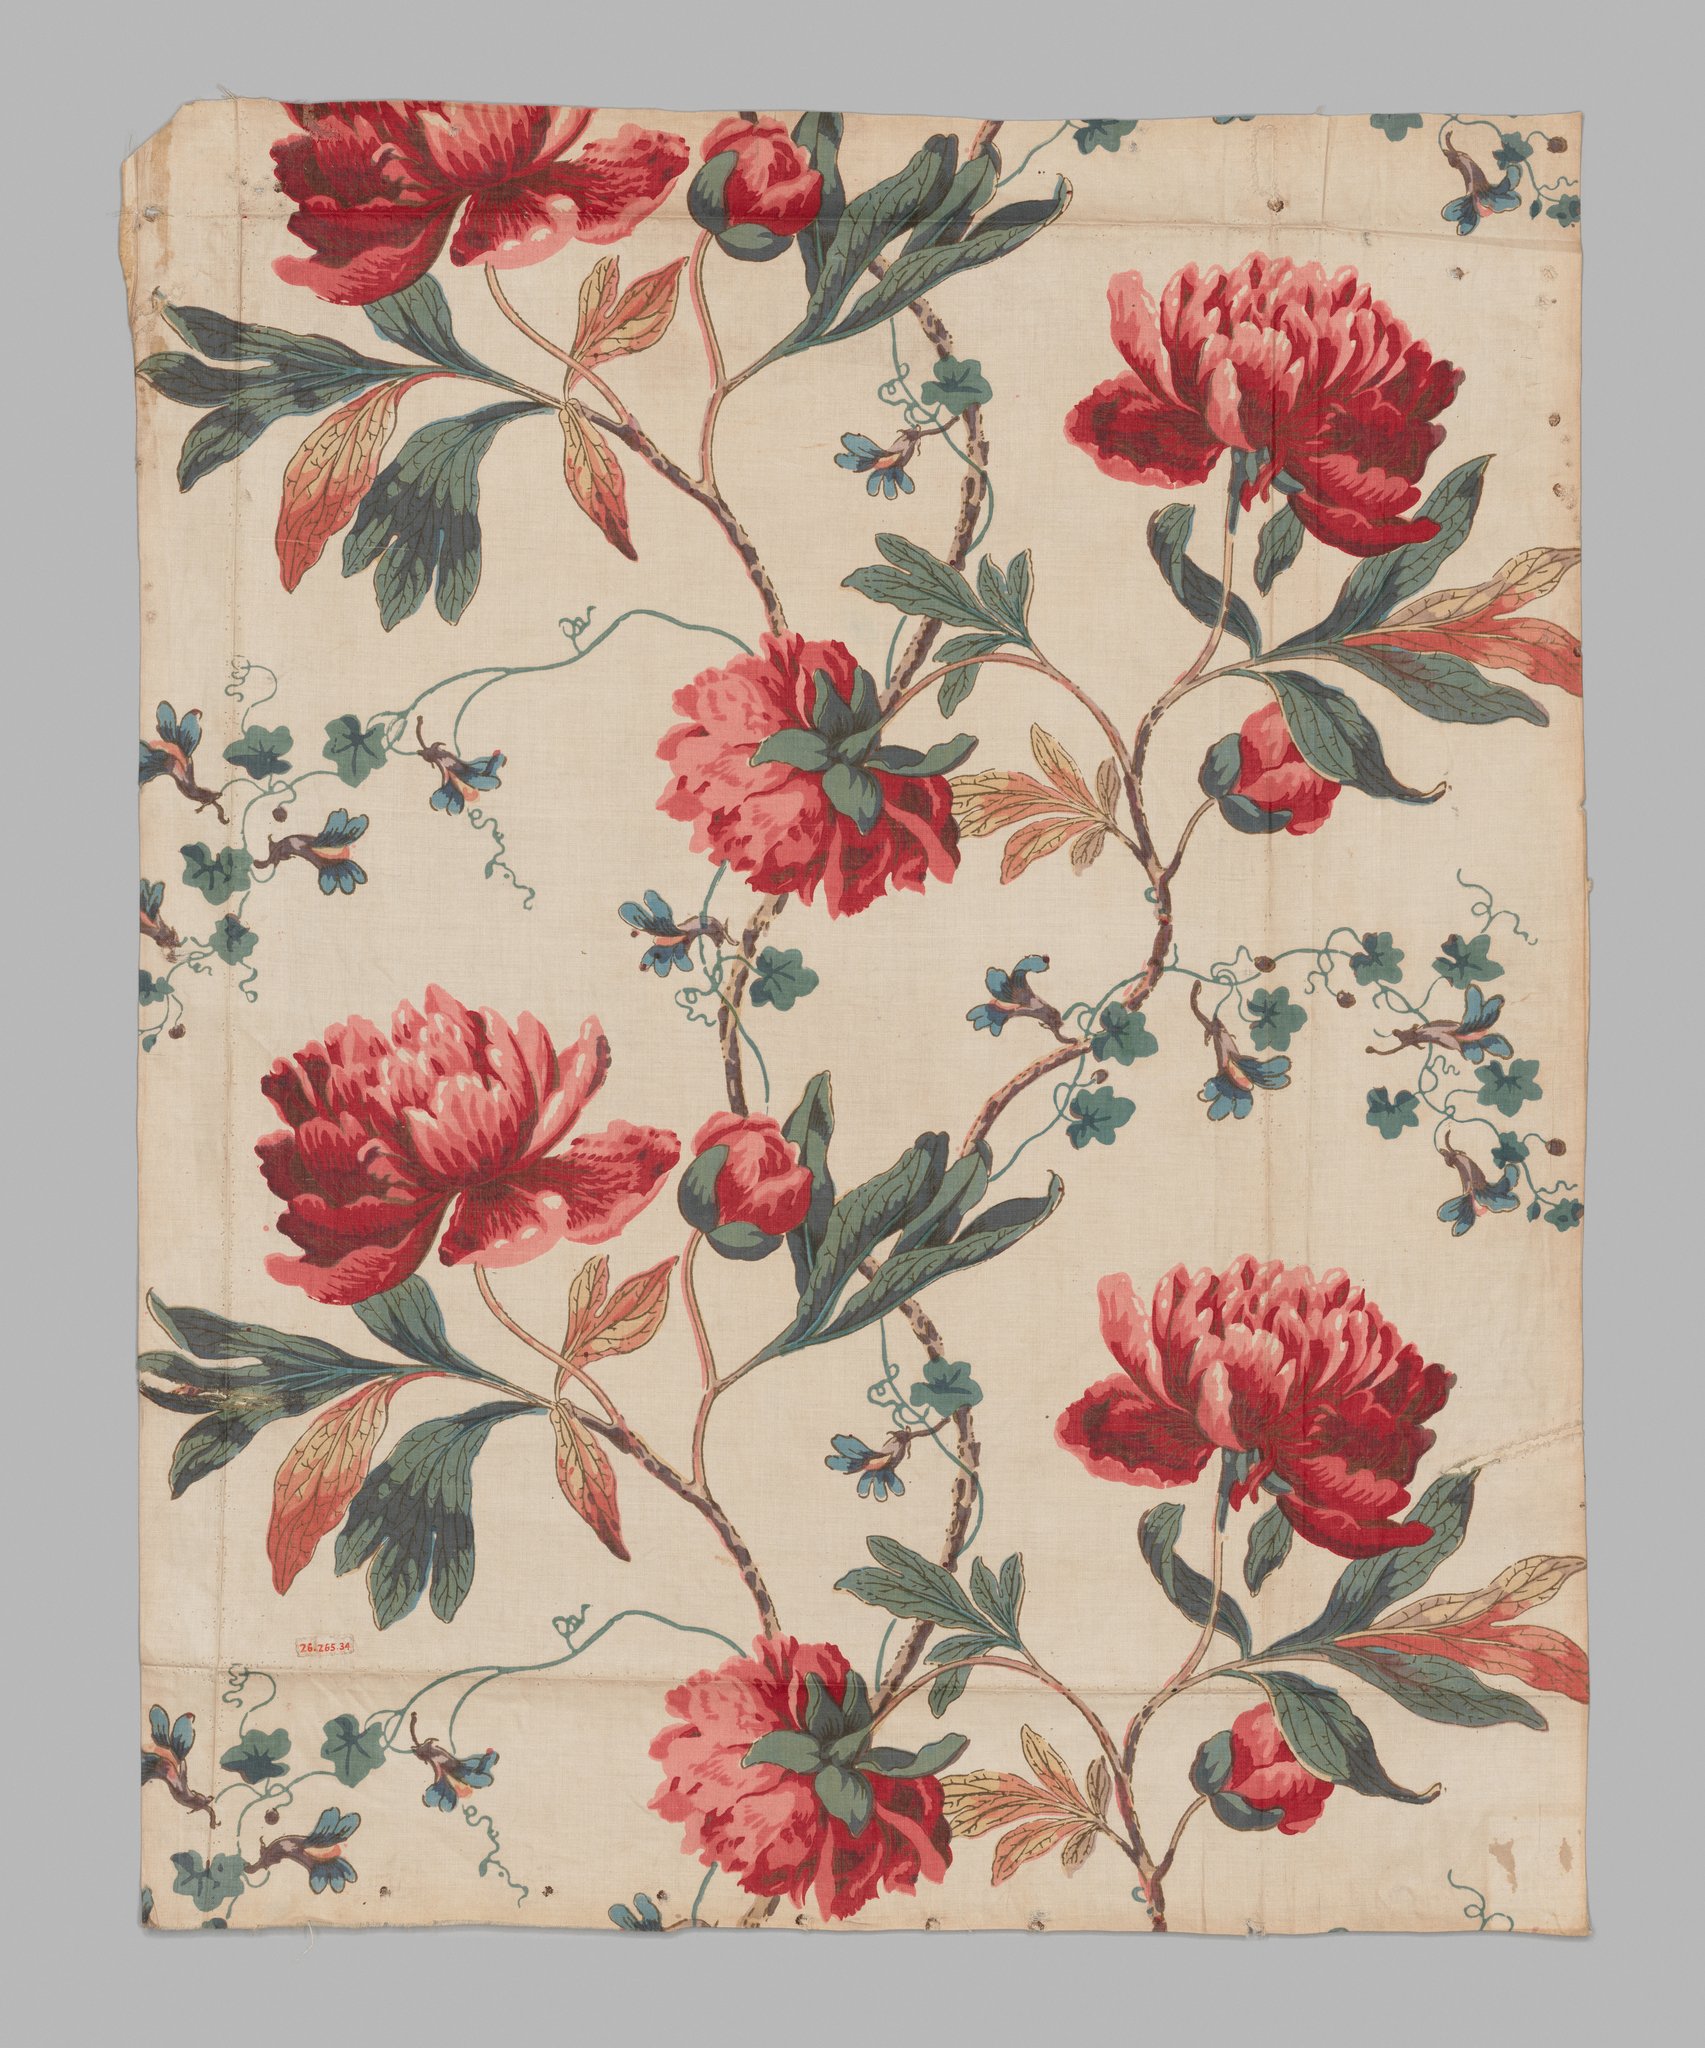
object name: floral print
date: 1801-1900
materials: cotton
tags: flowers